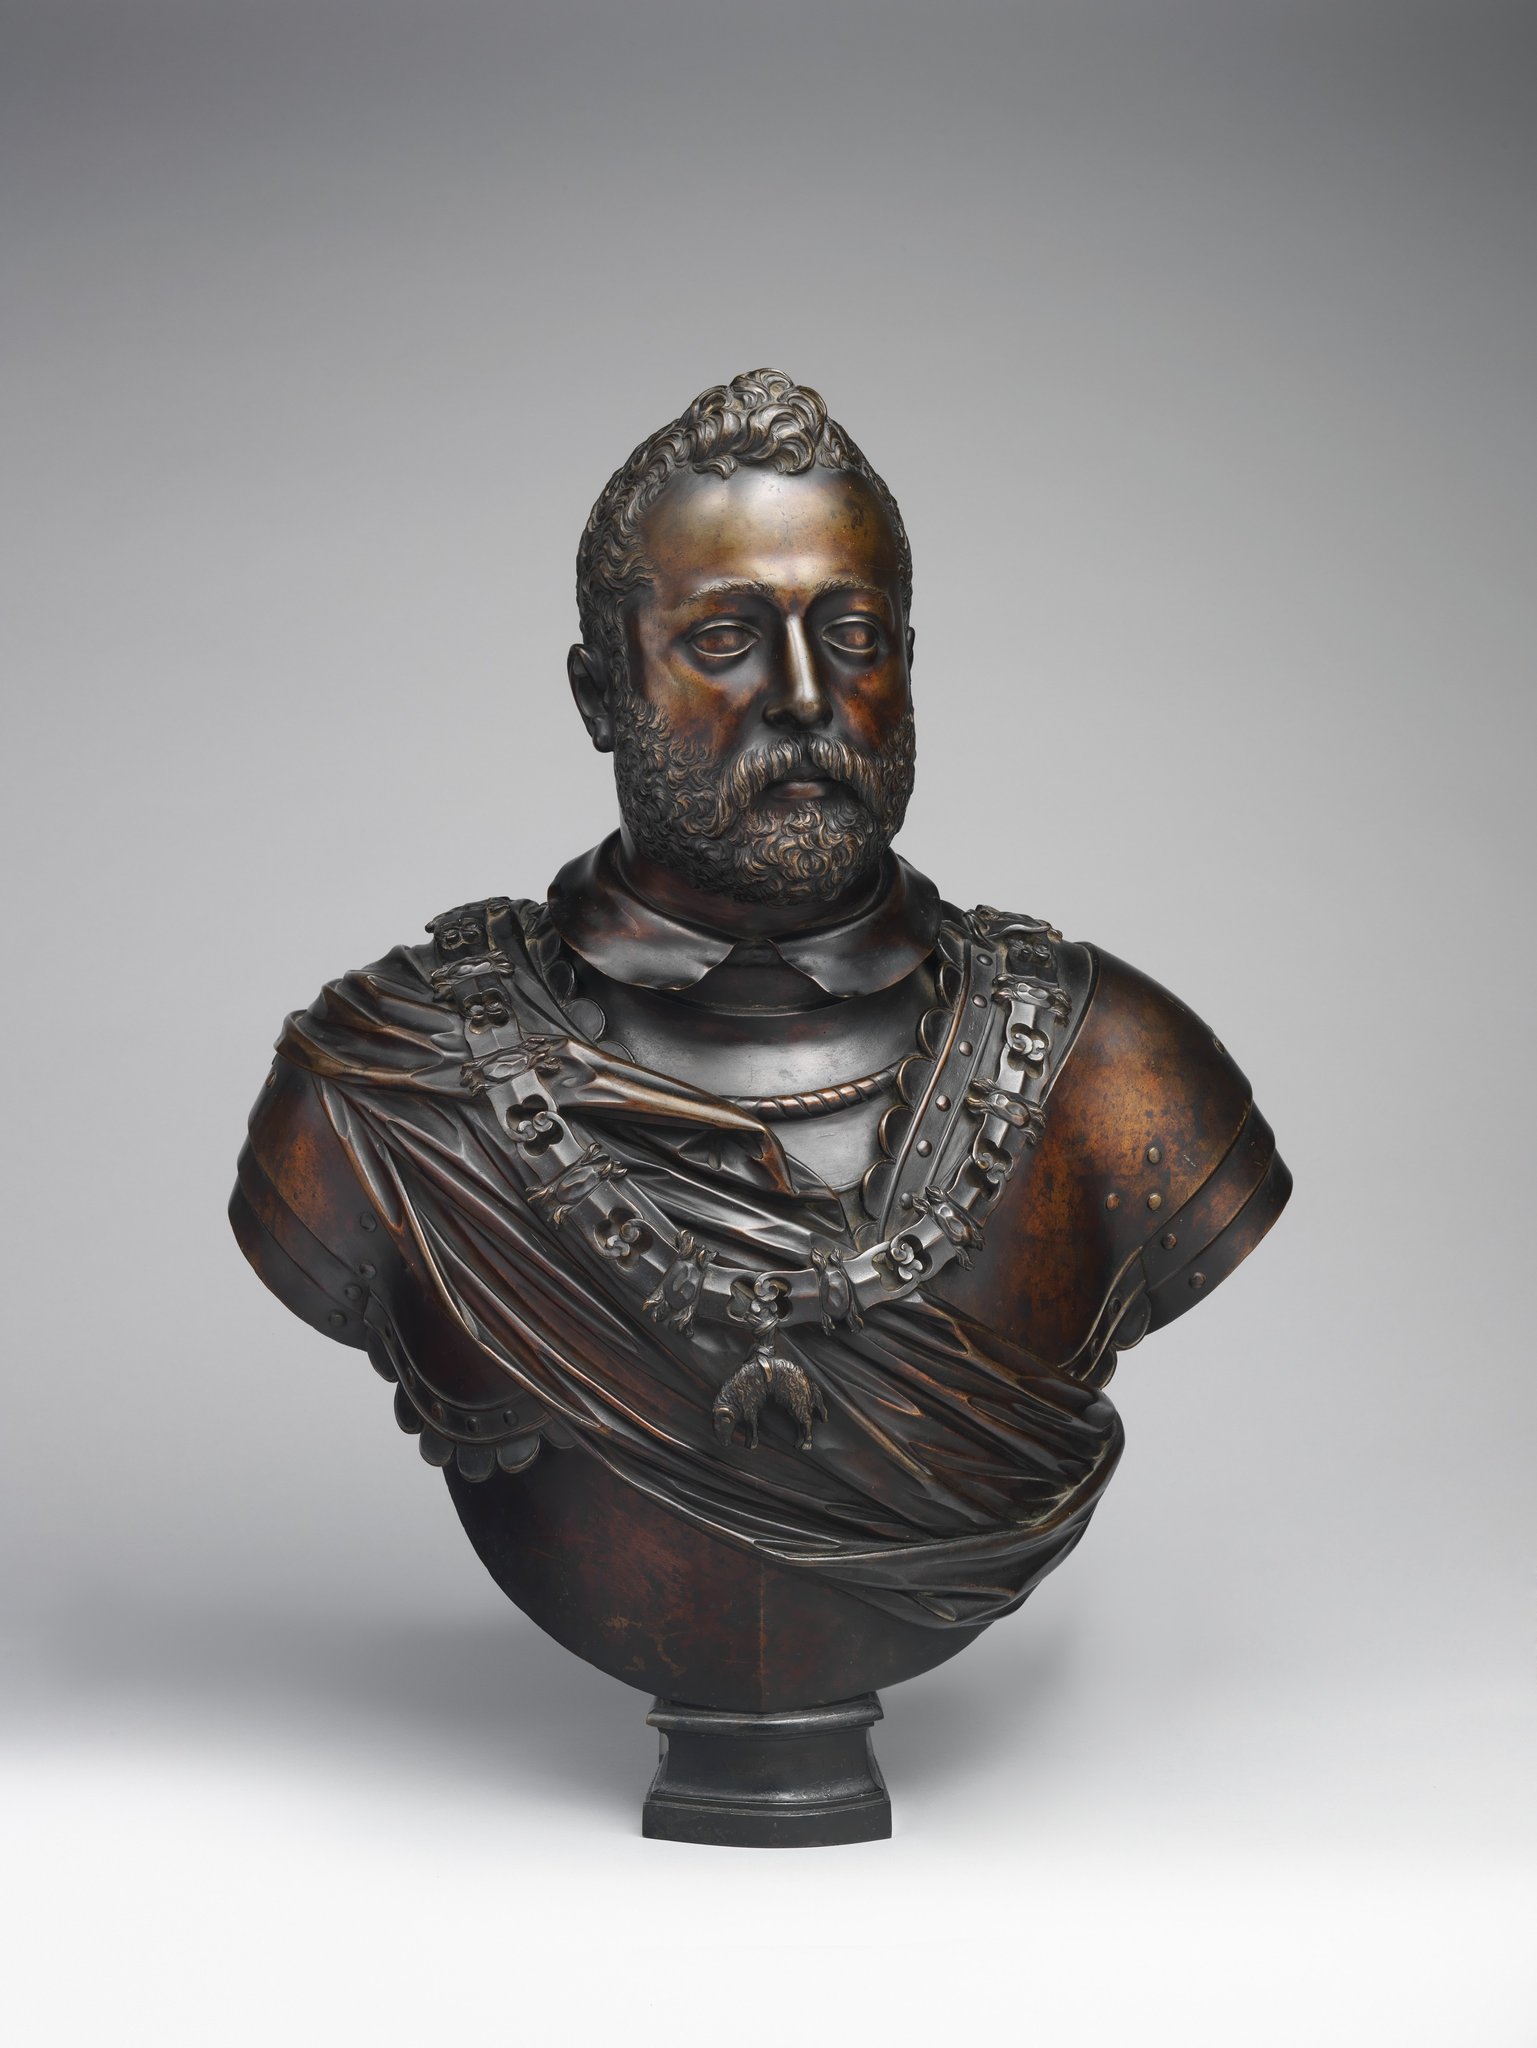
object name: bust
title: Francesco I de' Medici, grand duke of Tuscany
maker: giambologna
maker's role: artist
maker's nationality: netherlandish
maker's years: 1529-1608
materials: bronze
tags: men,portraits